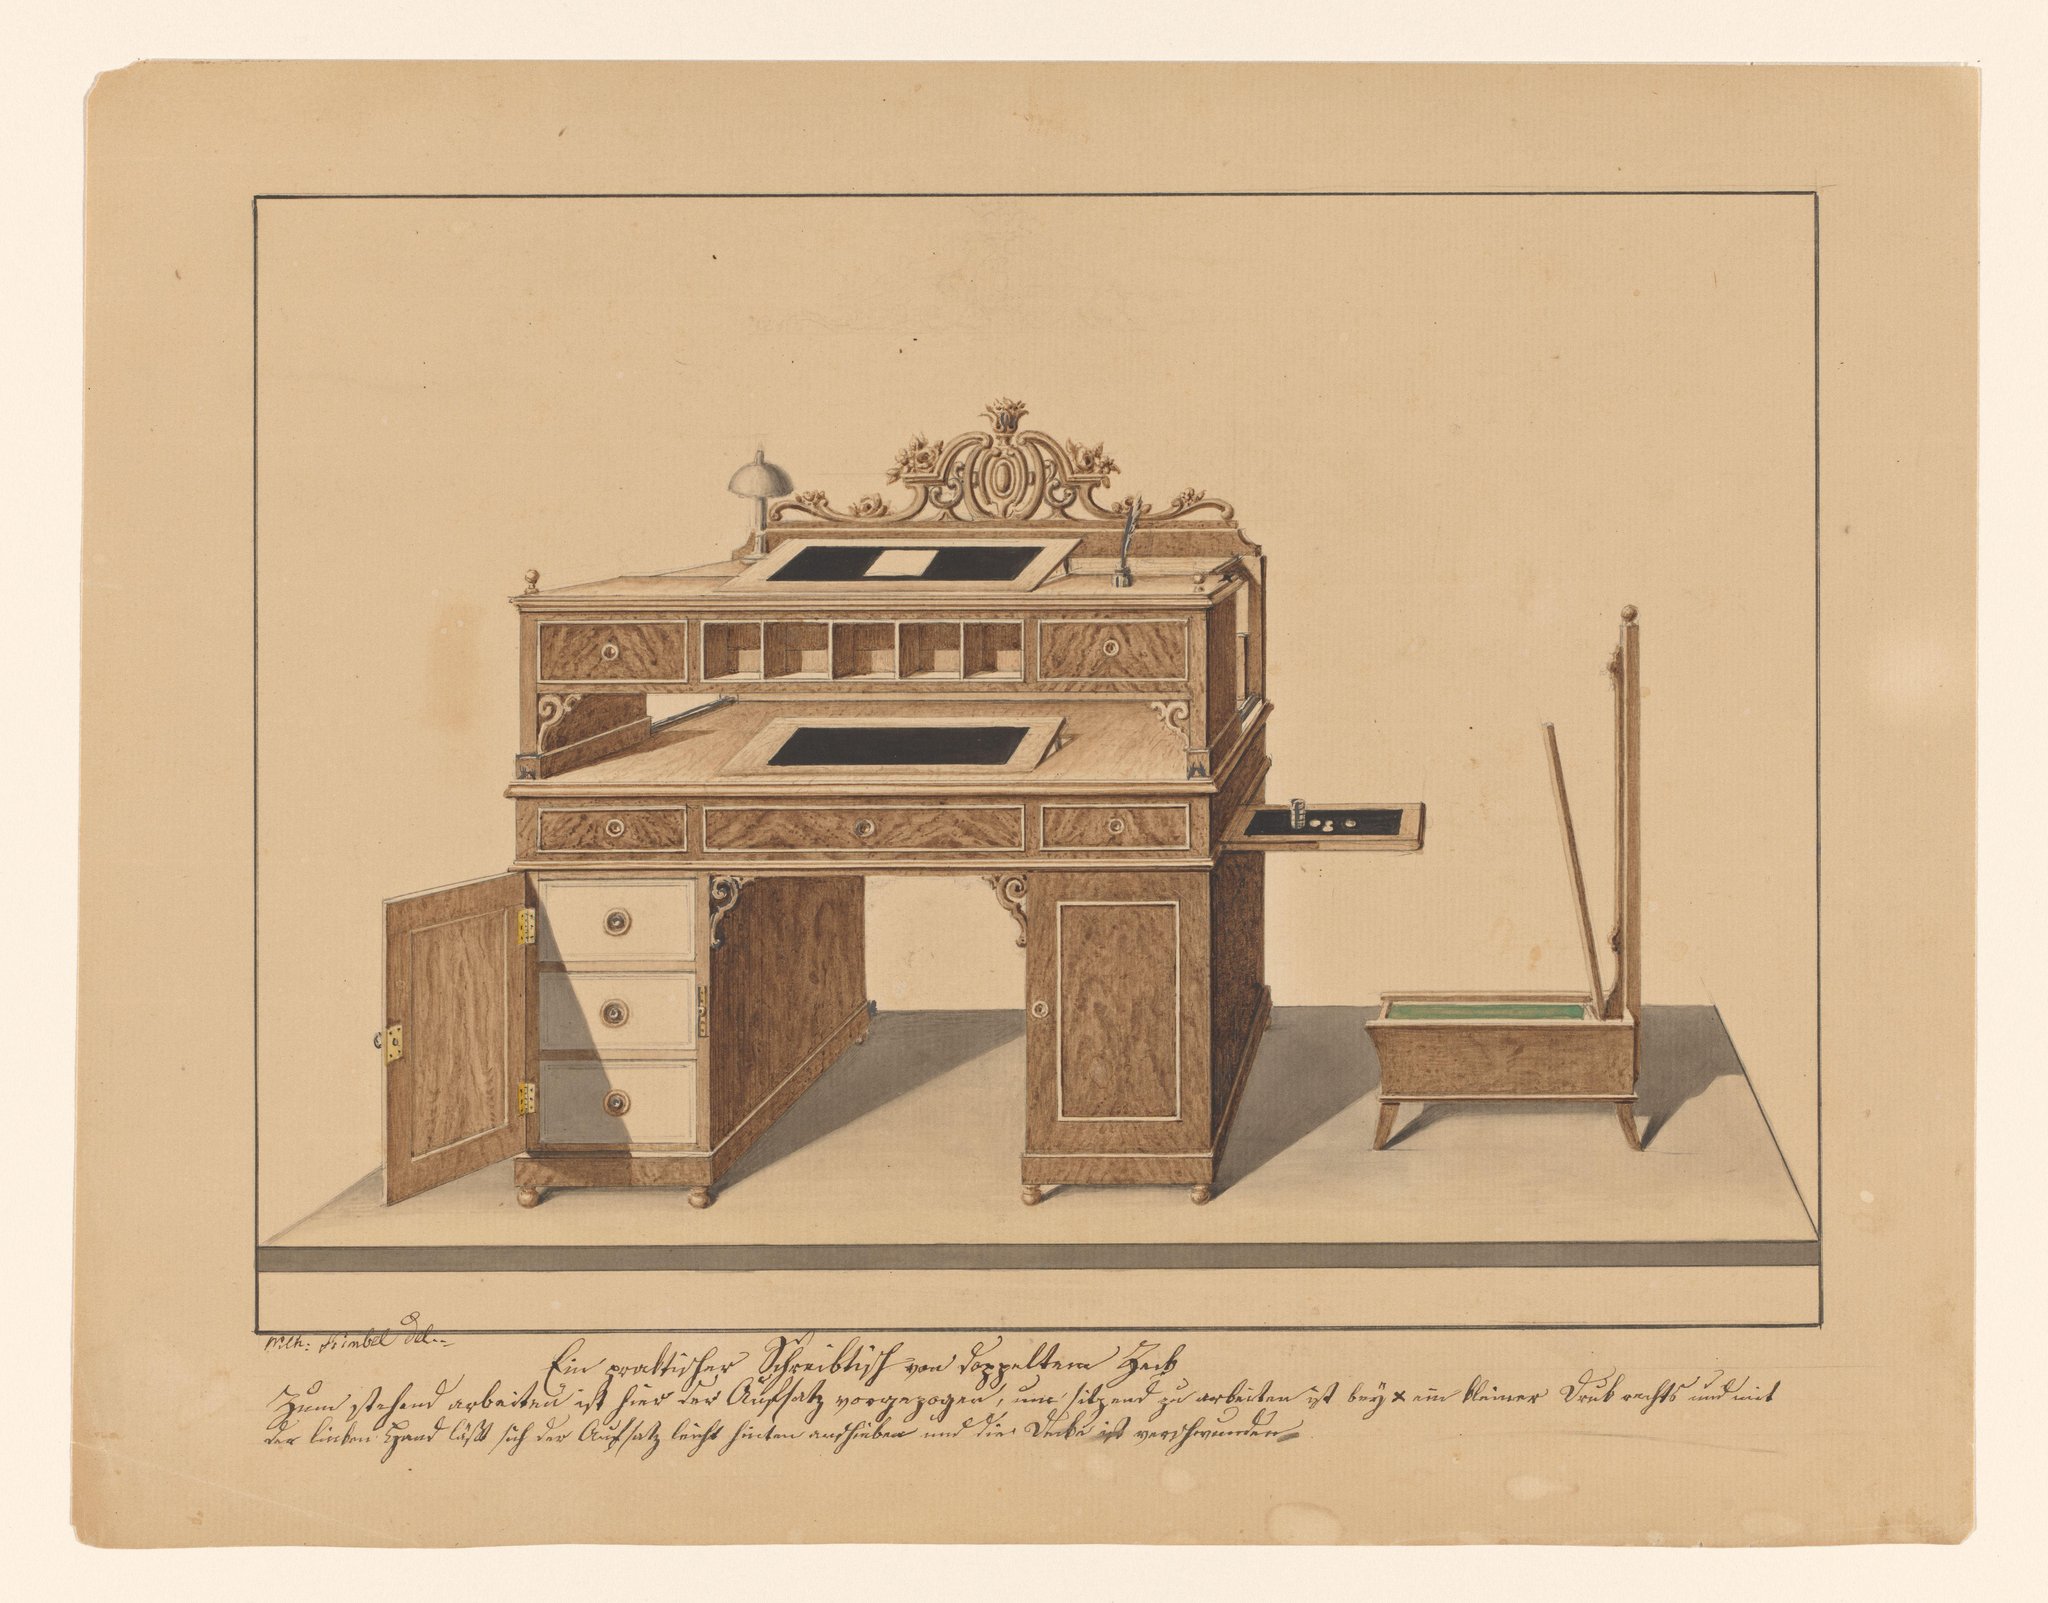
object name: drawing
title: Ontwerp voor een bureau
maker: wilhelm kimbel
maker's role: draughtsman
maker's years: 1786-1869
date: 1840-1845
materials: graphite, ink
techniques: brush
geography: mainz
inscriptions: signature: ‘Wilh: Kimbel delin’, inscription: ‘Ein pracktischer Schreibtisch von doppeltem Zweck / Zum stehend arbeiten ist hier der Aufsatz vorgezogen, um sitzend zu arbeiten ist beij x ein kleiner Drub rechts und mit / der linken Hand lässt sich der Aufsatz leicht hinten anschieben und die Drube ist verschwunden.’